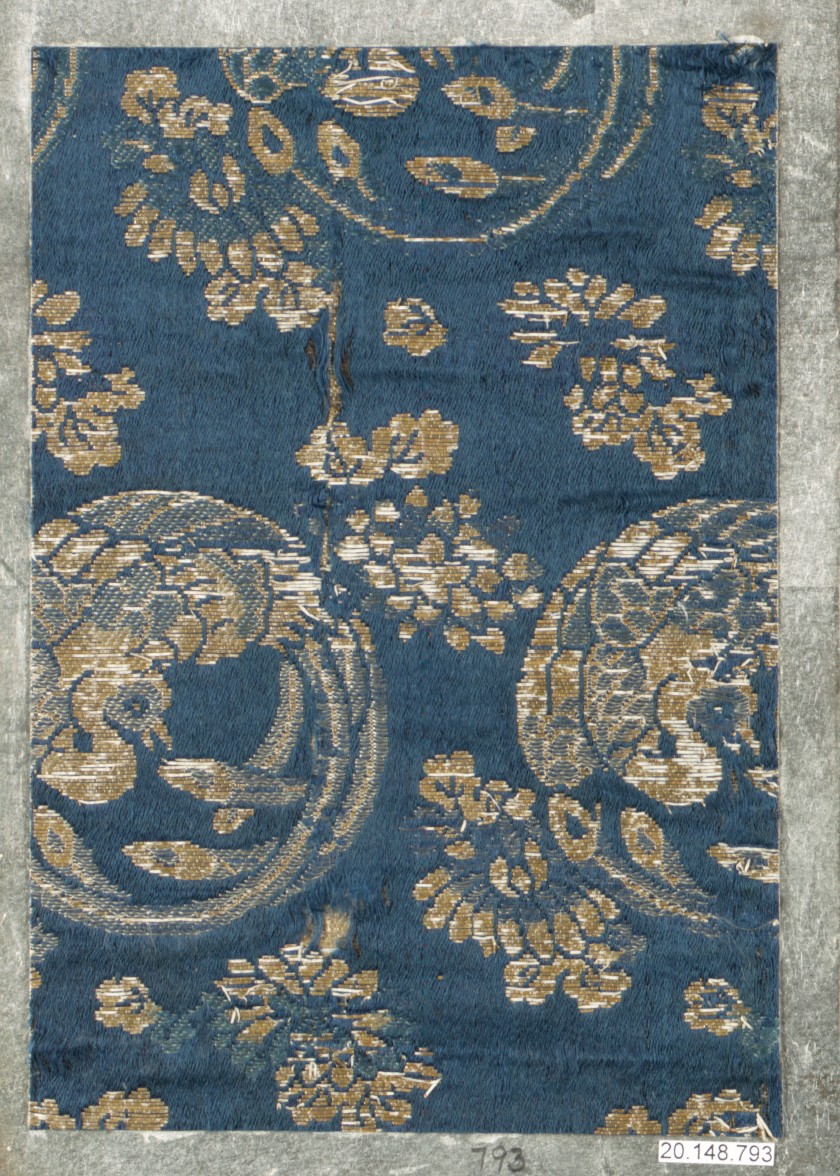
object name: piece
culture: japanese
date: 1601-1700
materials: silk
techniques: compound weave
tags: birds,flowers